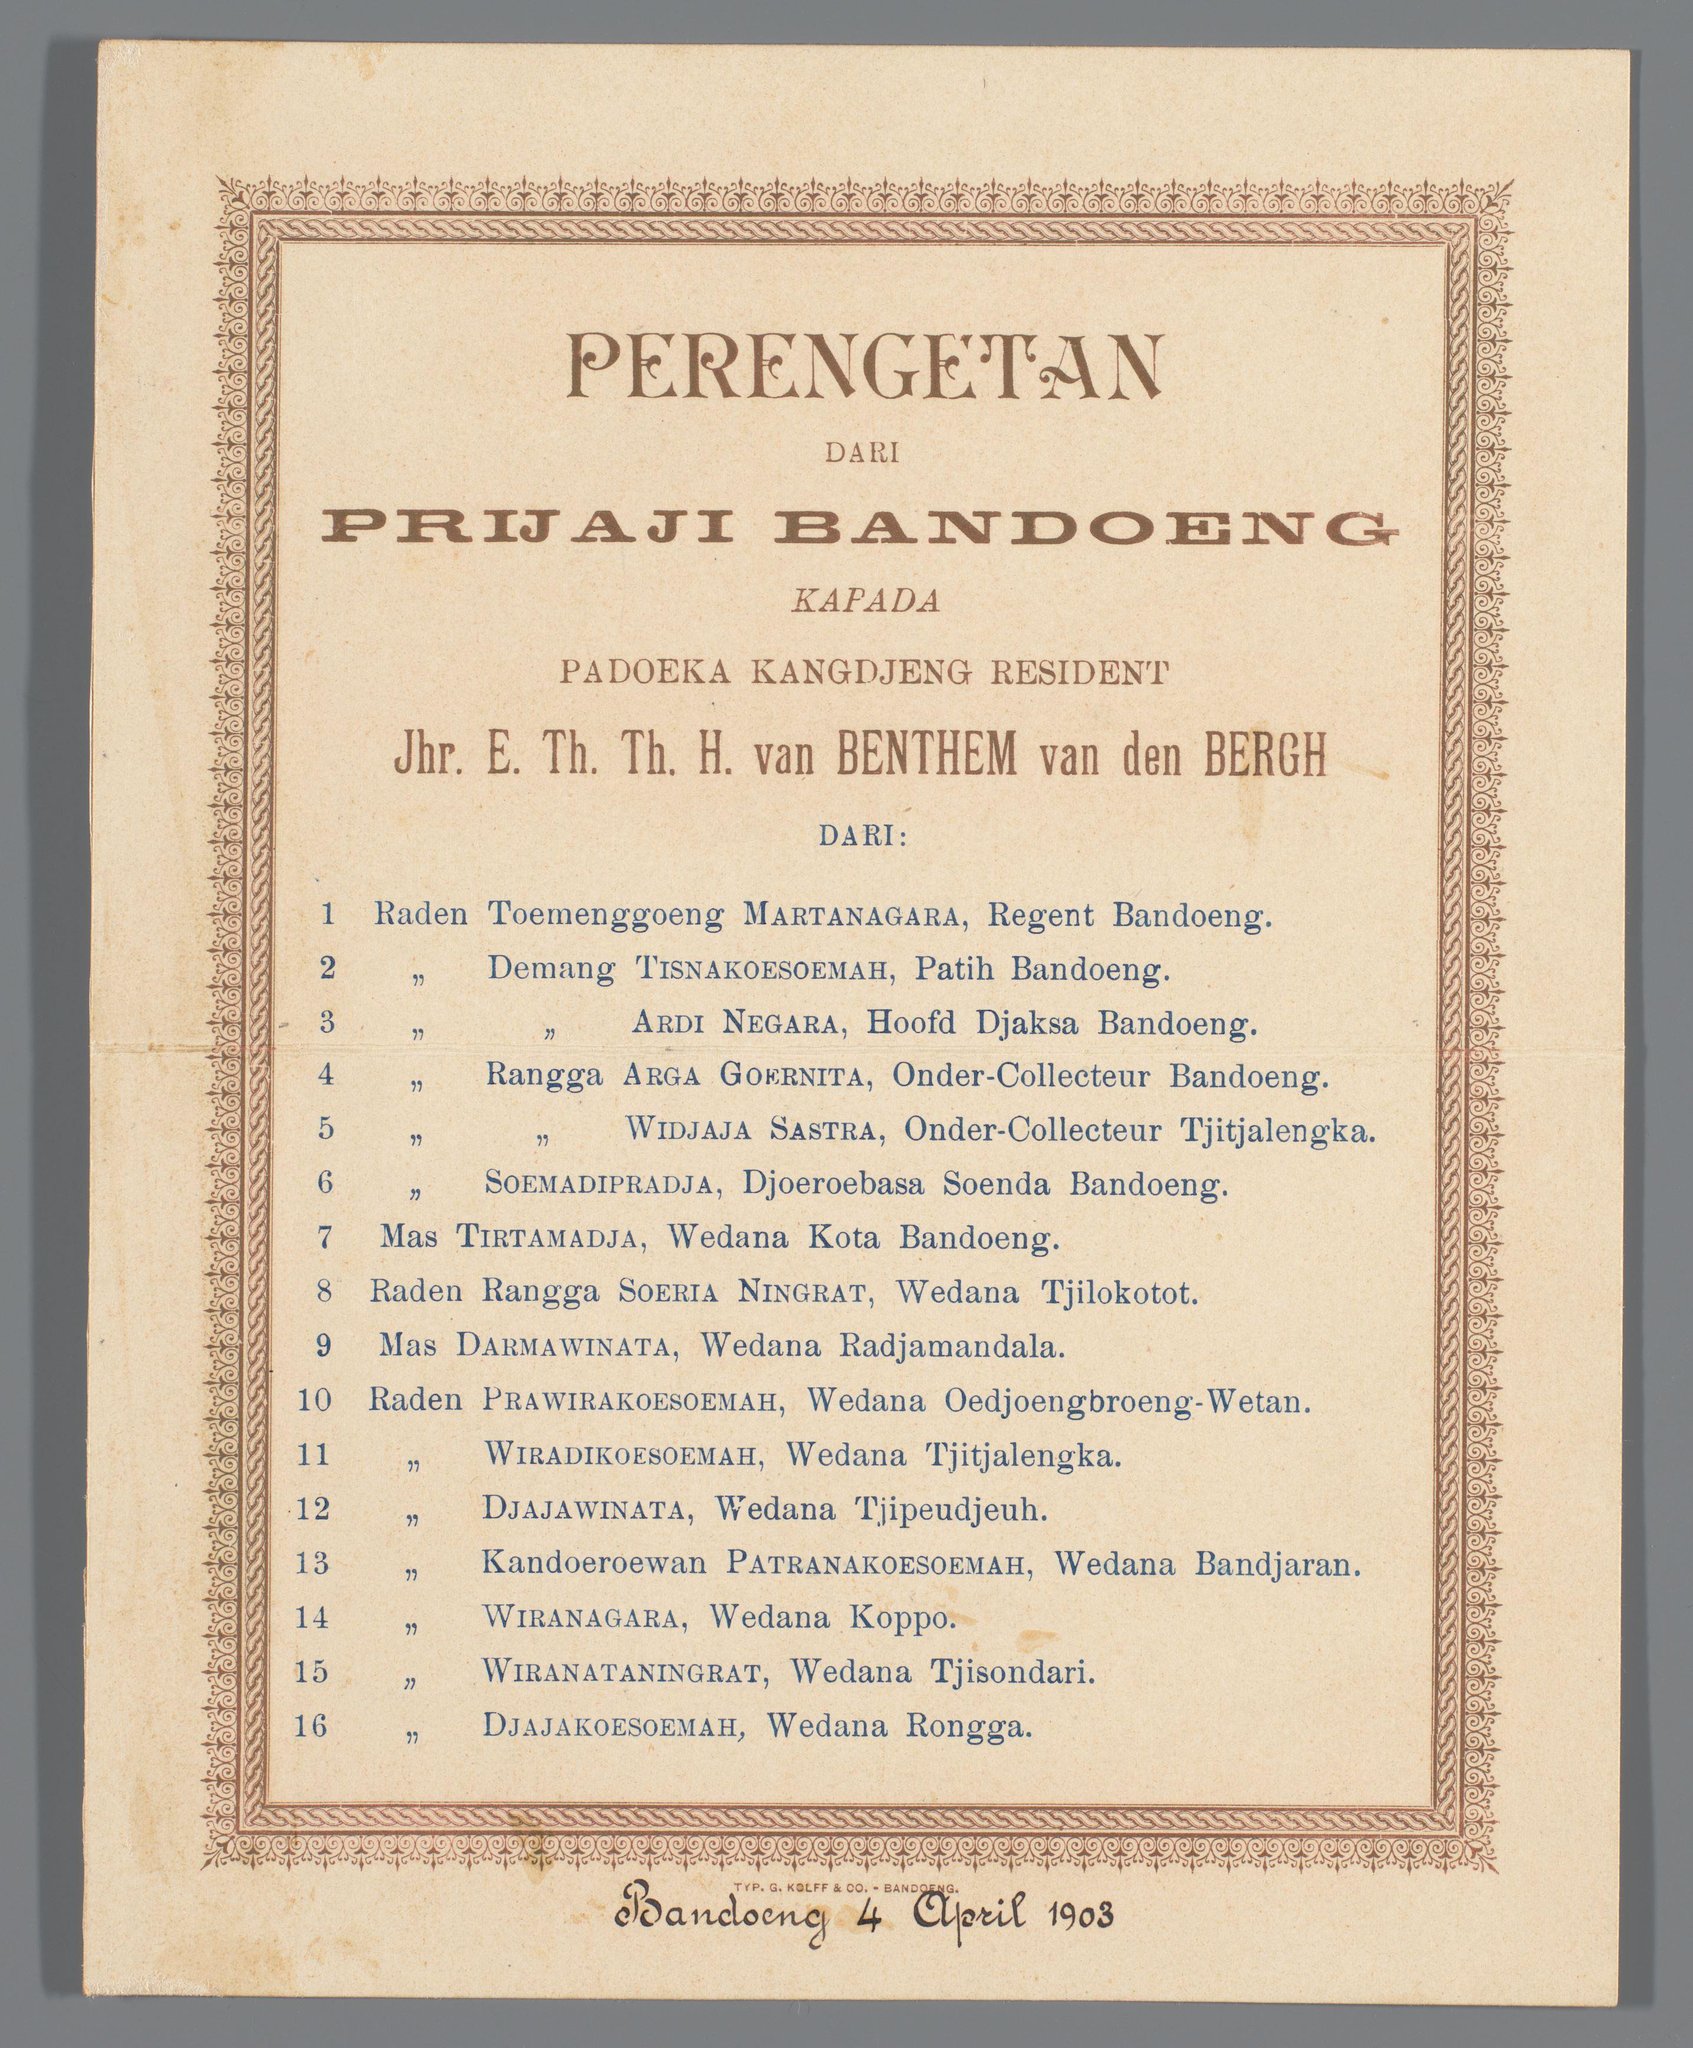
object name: document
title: Perengetan dari prijaji Bandoeng kapada padoeka kangdjeng resident Jhr. E.Th.H. van Benthem van den Bergh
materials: cardboard, ink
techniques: printing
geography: bandung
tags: the hague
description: 16 Namen met personen die bijgedragen hebben aan de degenstok met gouden knop met geciseleerd geslachtswapen 1903, geschonken aan de afgetreden Resident der Preanger-Regentschappen Jhr. E.Th.H. van Benthem van den Bergh. Tekst gedrukt in blauw en goud met gouden versierd kader. Aan de onderkant is met zwart balpoint de plaats en datum geschreven. In het midden een vouw.